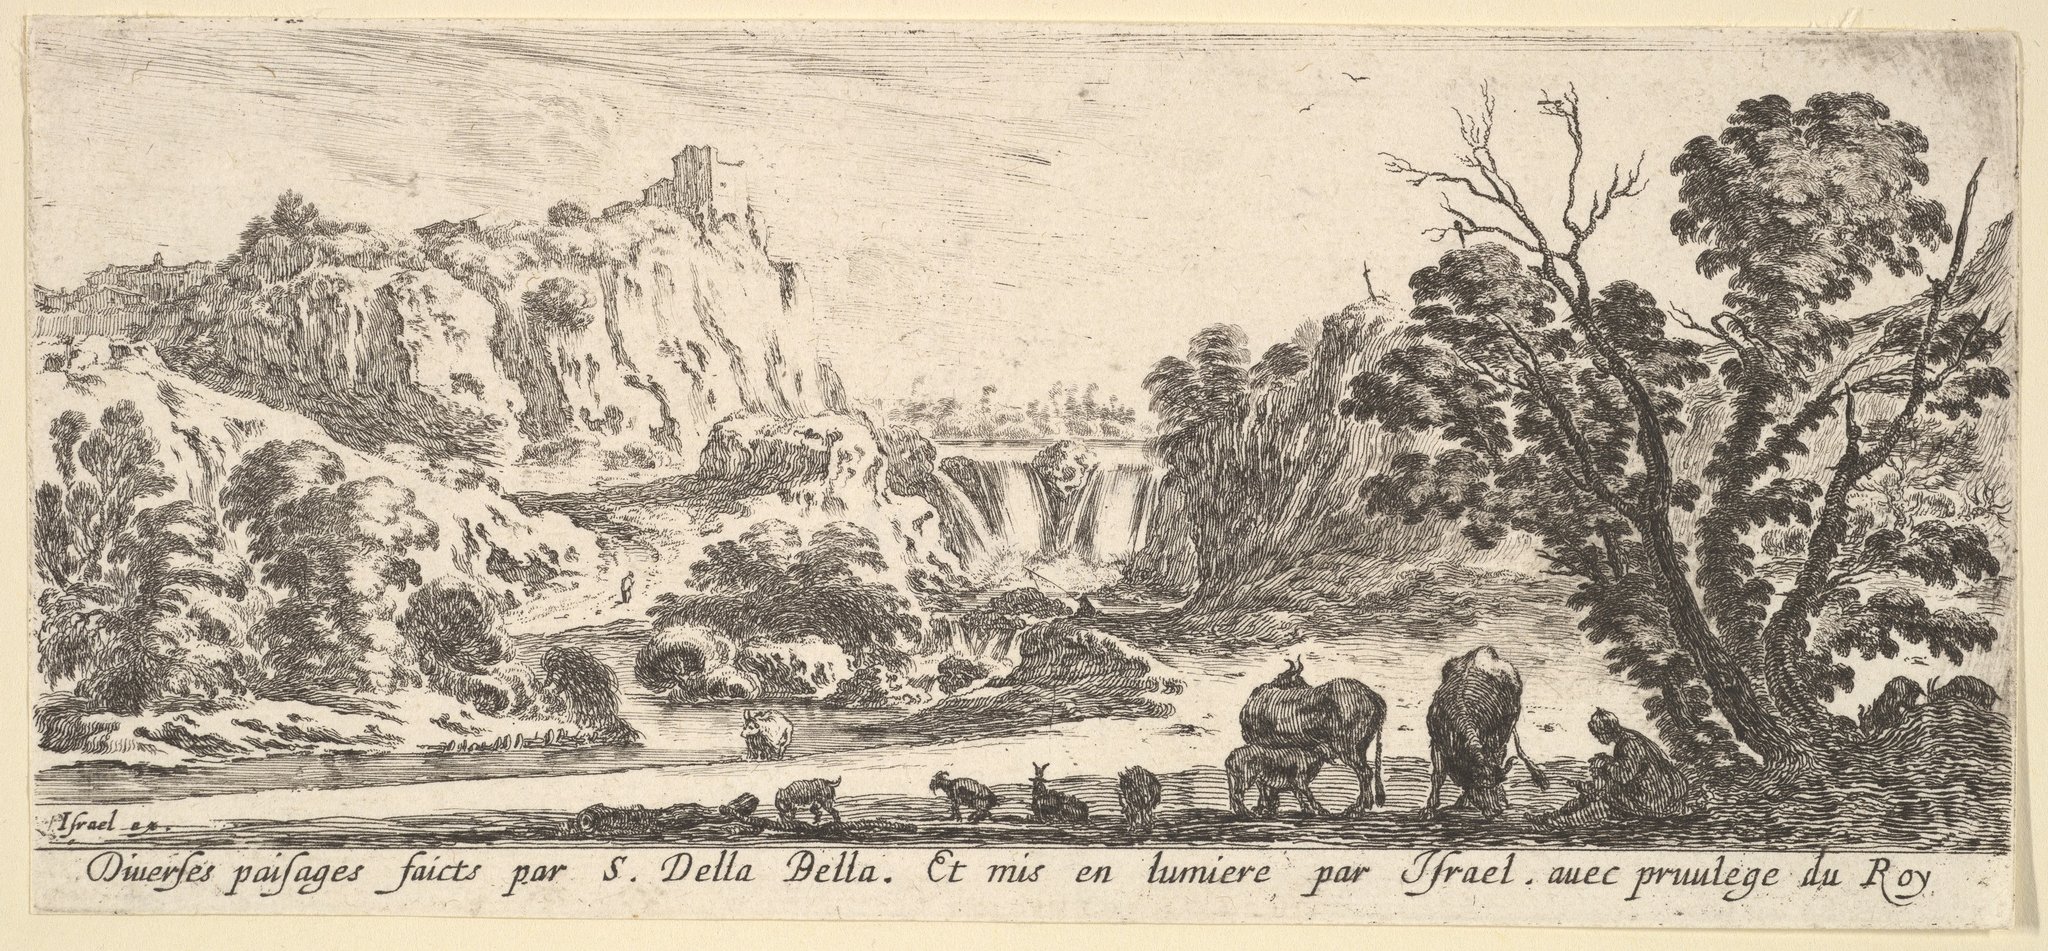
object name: print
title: A waterfall descending from the mountains in the center background, various animals and a woman and child beneath a tree in the foreground, from "Various Landscapes" (Divers Paysages)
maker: stefano della bella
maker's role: artist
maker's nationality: italian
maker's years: 1610-1664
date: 1641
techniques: etching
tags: animals,women,waterfalls,mountains,landscapes